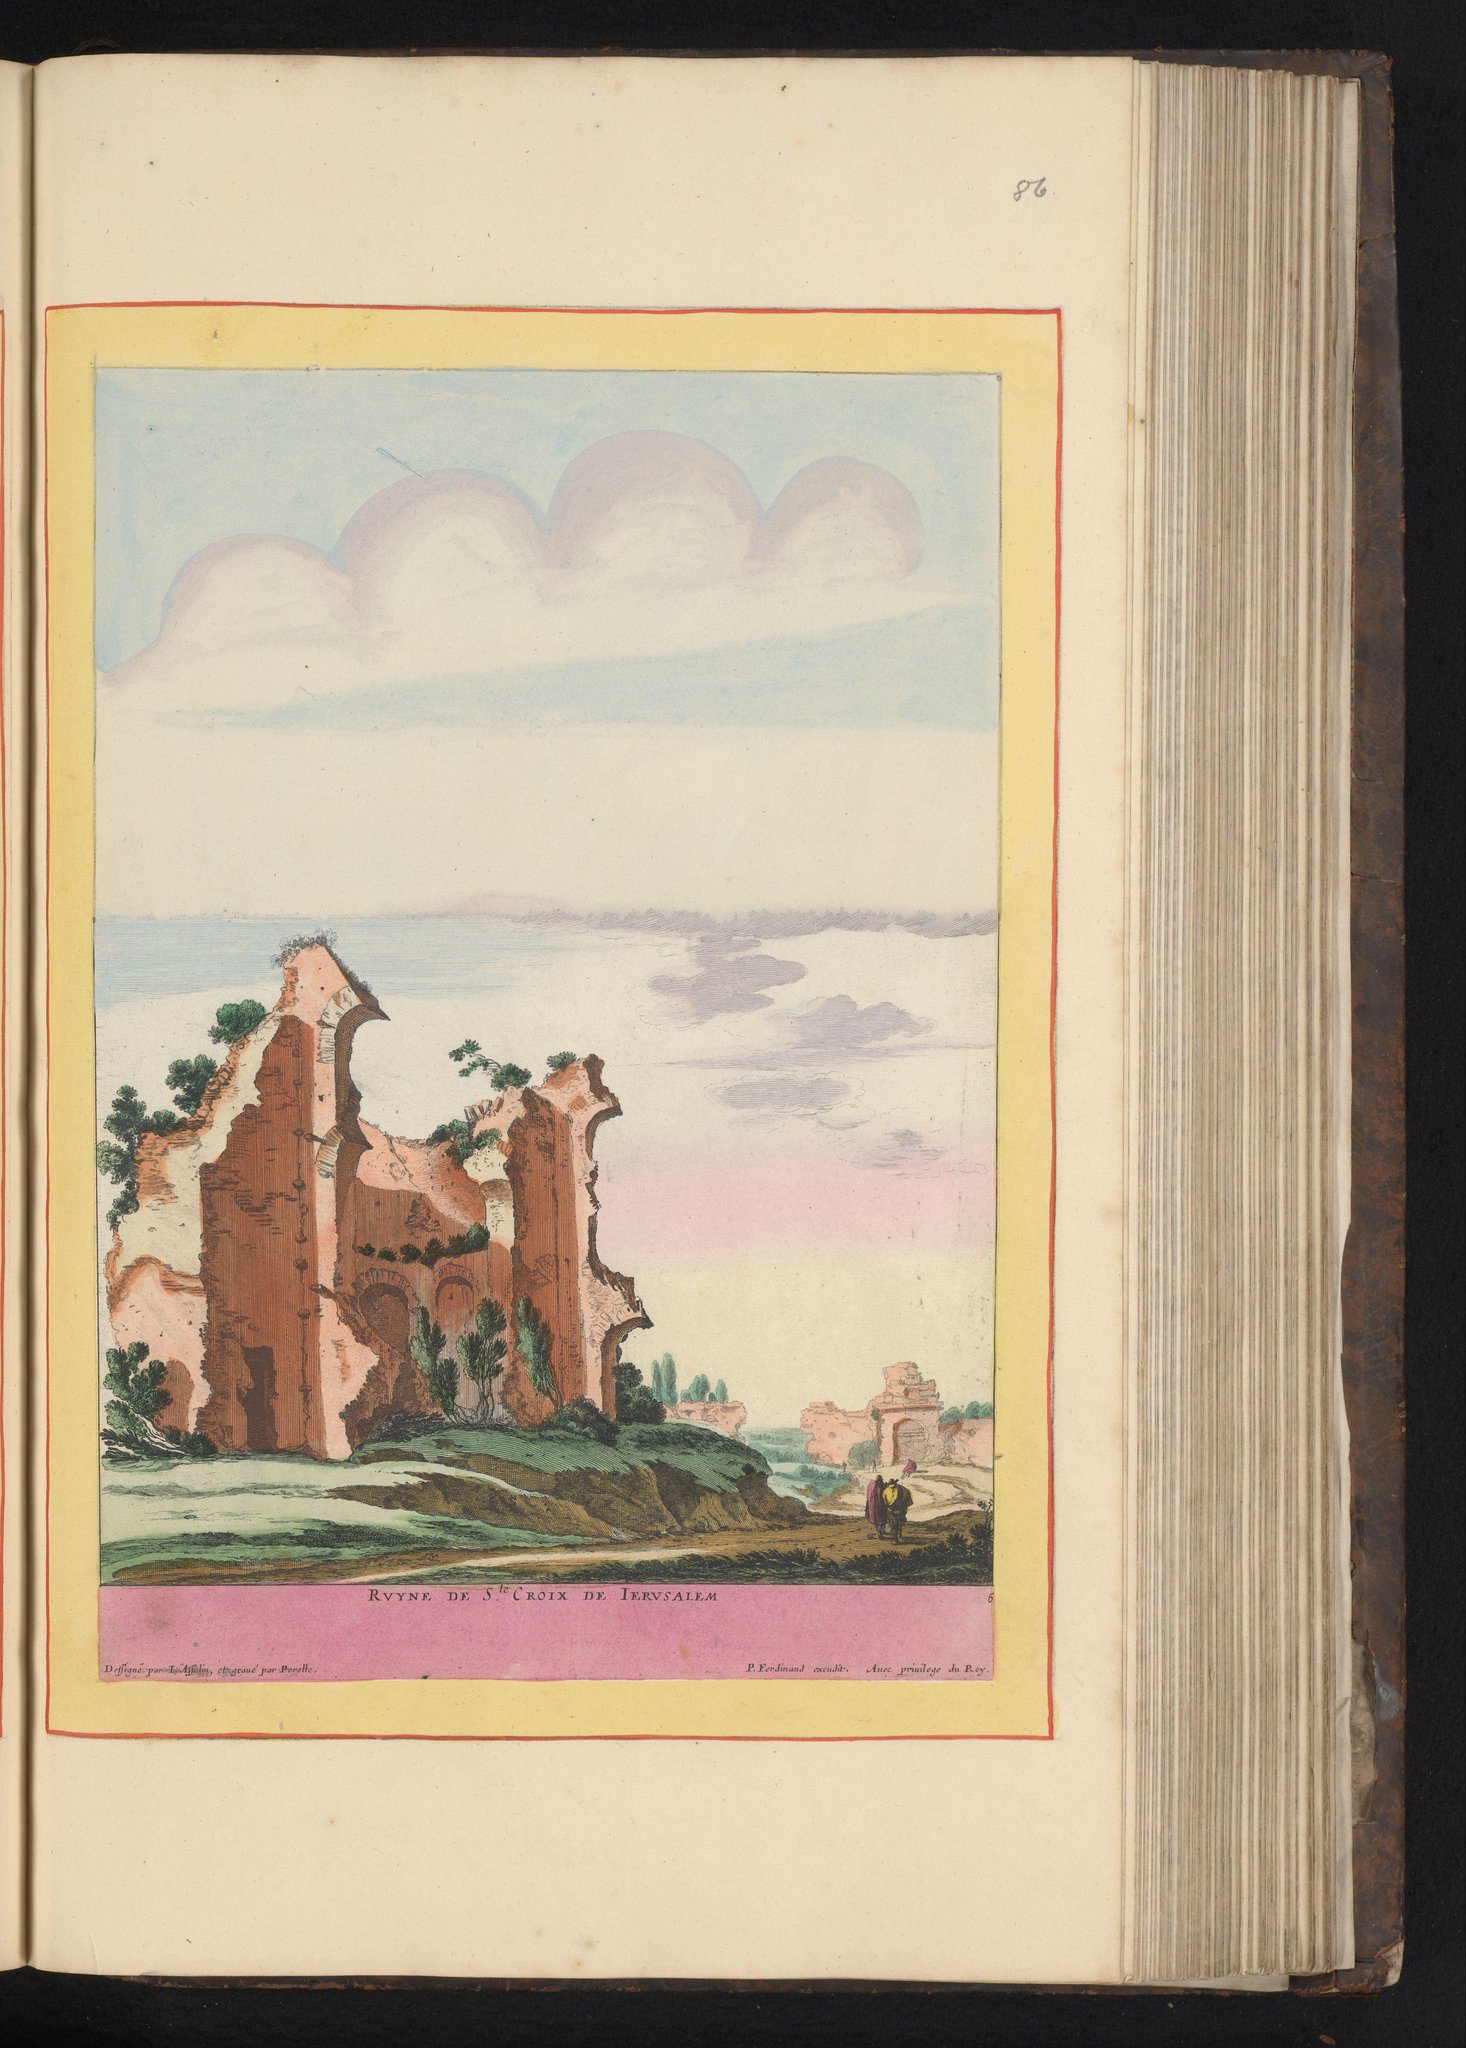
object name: print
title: Landschappen met Romeinse ruïnes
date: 1620-1657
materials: paper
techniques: colour, etching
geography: france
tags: ruin of a building ~ architecture, landscape with ruins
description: Deze prent maakt deel uit van een reeks van zes prenten met landschappen met Romeinse ruïnes. De prent is langs de bovenrand van de voorstelling afgescheurd. De voorstelling is aan de bovenzijde aangevuld met een geschilderde lucht.